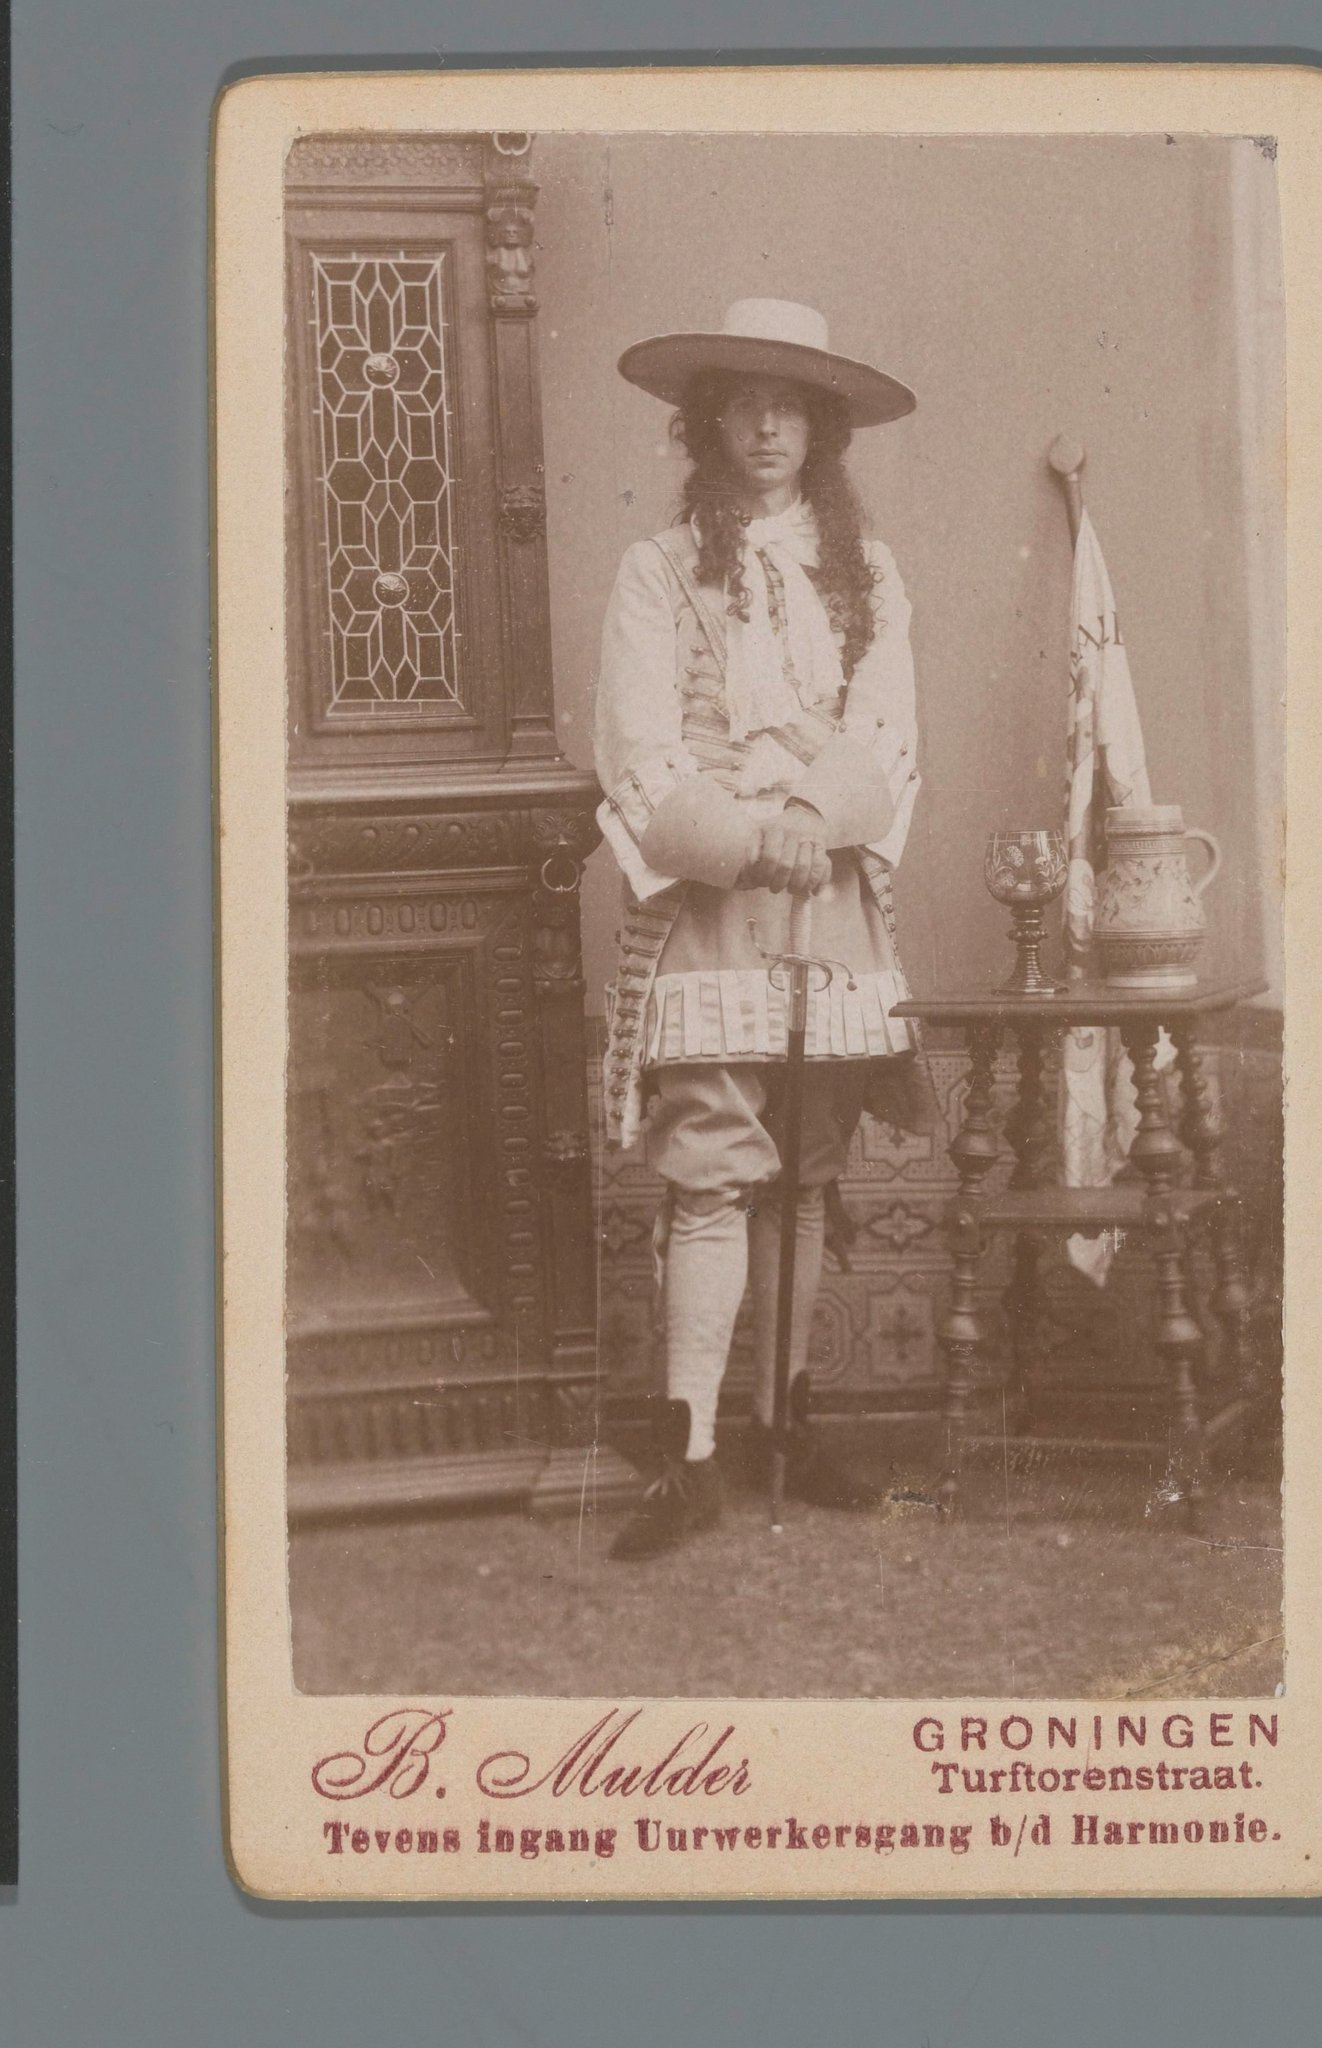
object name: photograph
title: Portret van een onbekende Groningse student in maskeradekostuum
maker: berend mulder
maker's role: fotograaf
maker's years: 1854-1926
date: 1886-1897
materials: paper, cardboard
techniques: collodion silver print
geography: groningen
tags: students' pageant, costumes used in pageants, anonymous historical person portrayed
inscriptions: inscription: ‘B. Mulder/ Groningen/ Turftorenstraat./ Tevens ingang Uurwerksgang b/d Harmonie’